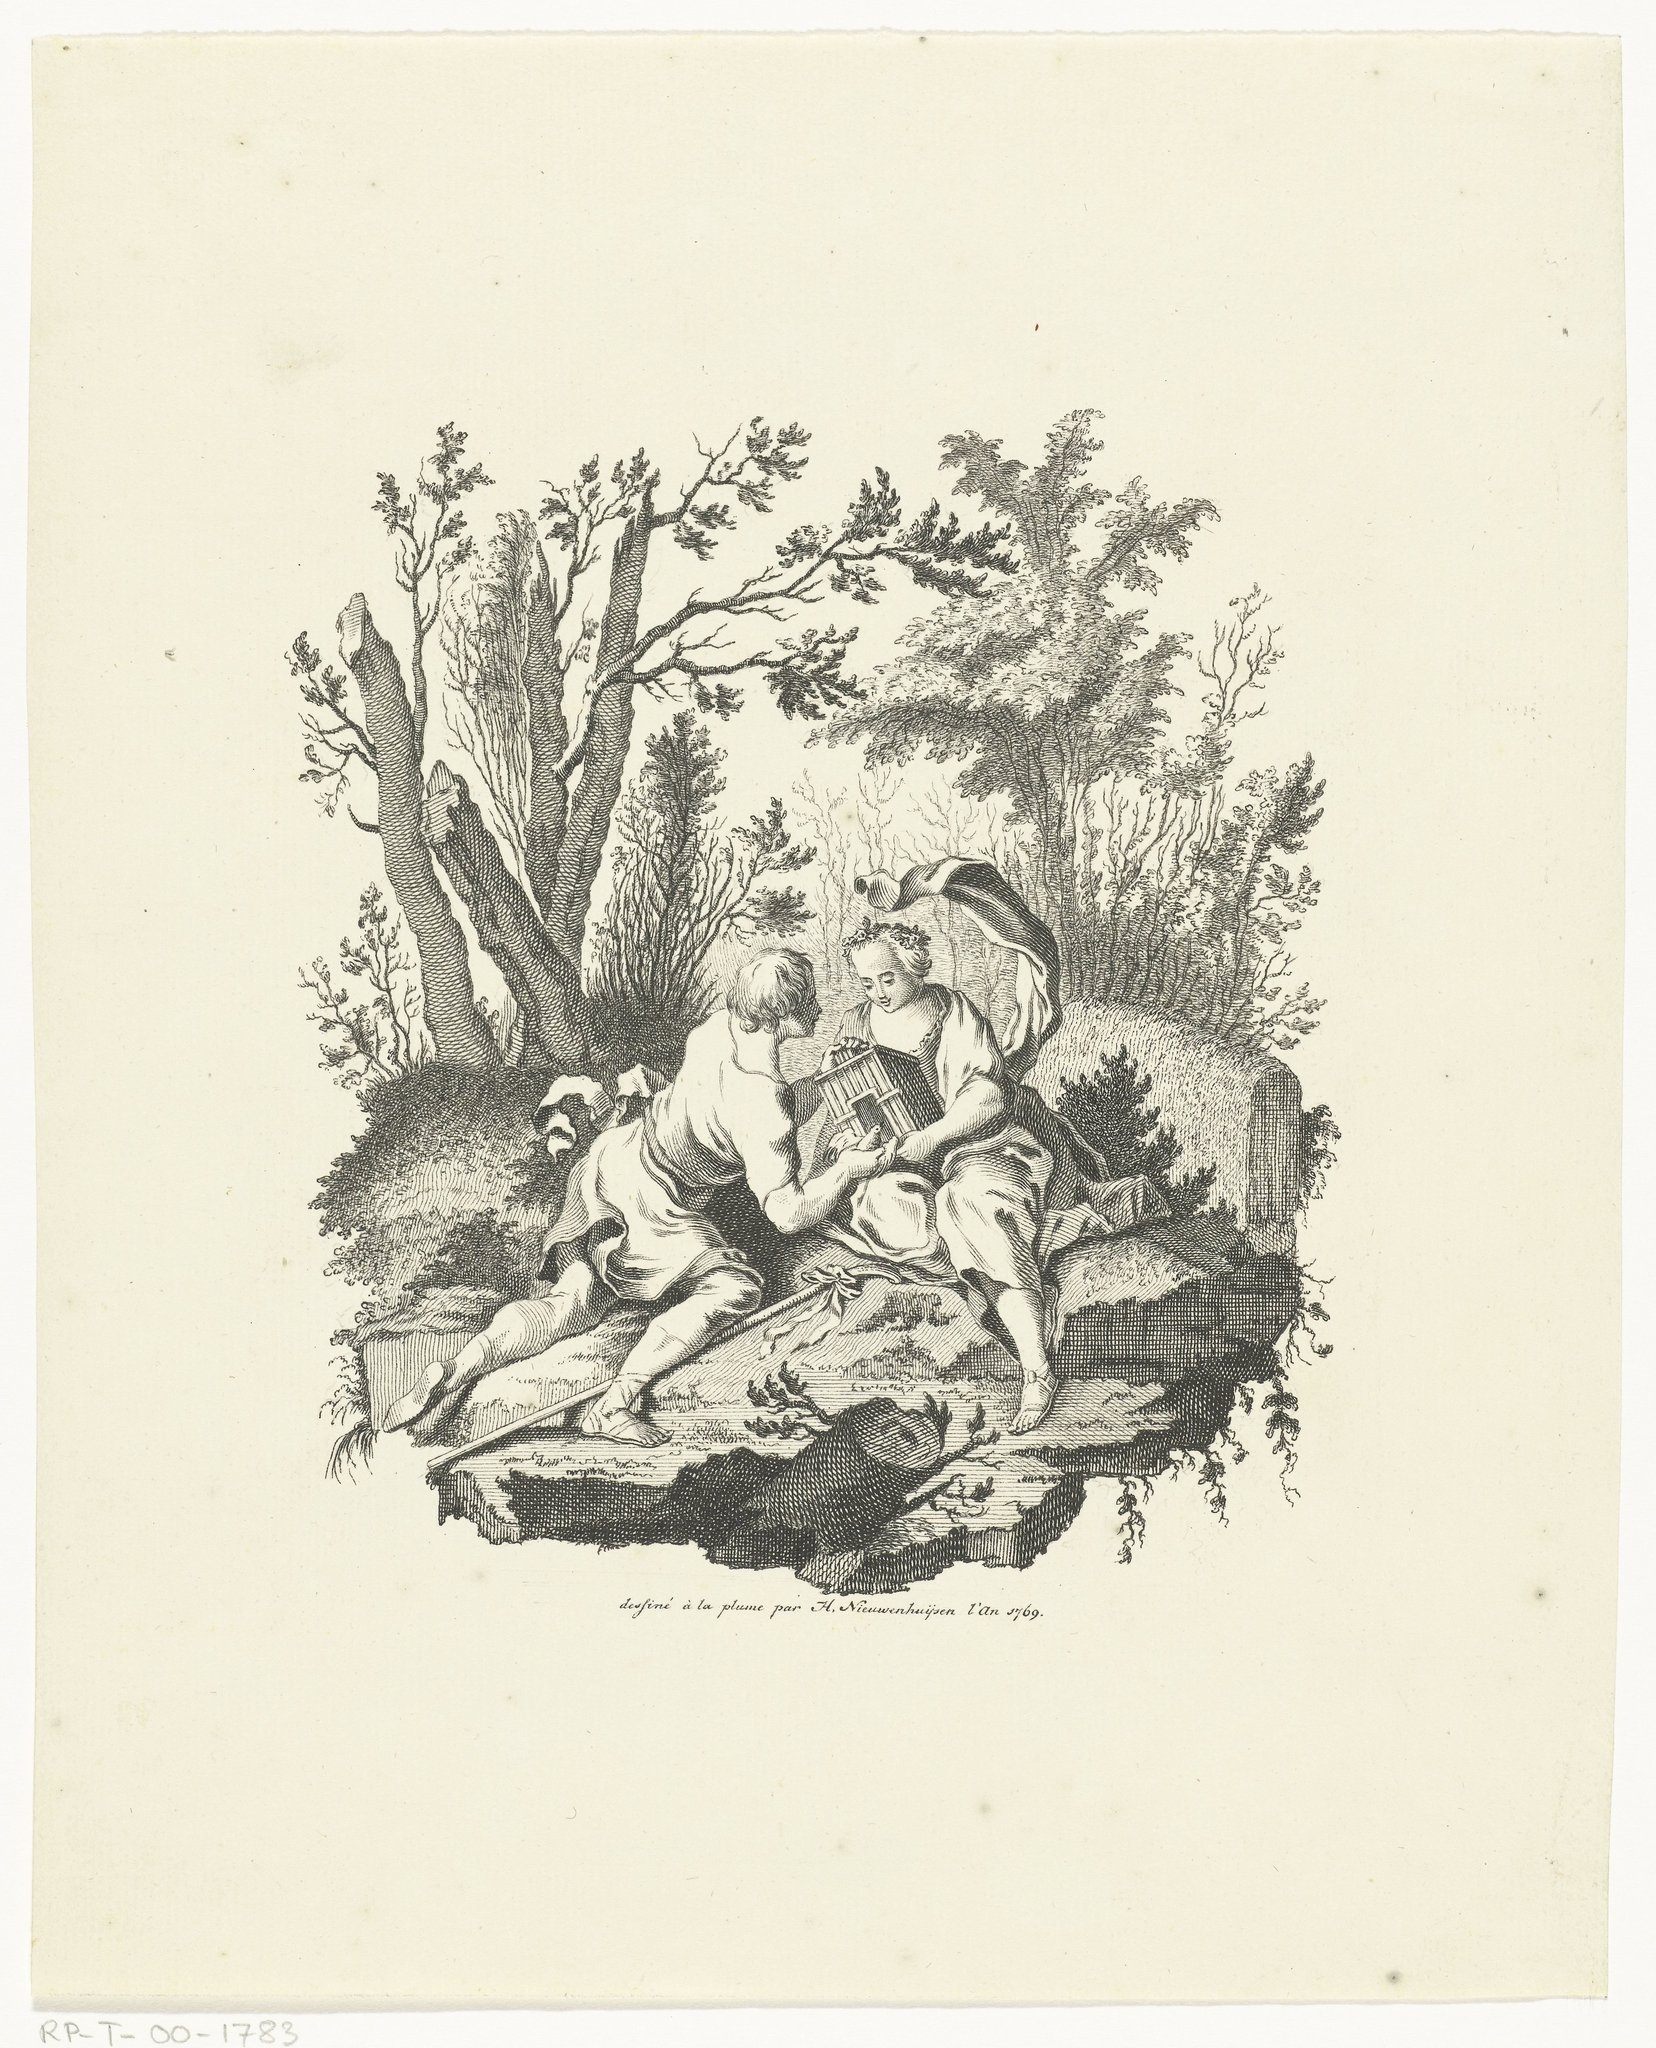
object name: drawing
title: Herder en herderinnetje met vogel en vogelhuisje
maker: hendrik nieuwenhuysen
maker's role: draughtsman, print maker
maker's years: 1747-1794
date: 1769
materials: ink, paper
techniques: pen